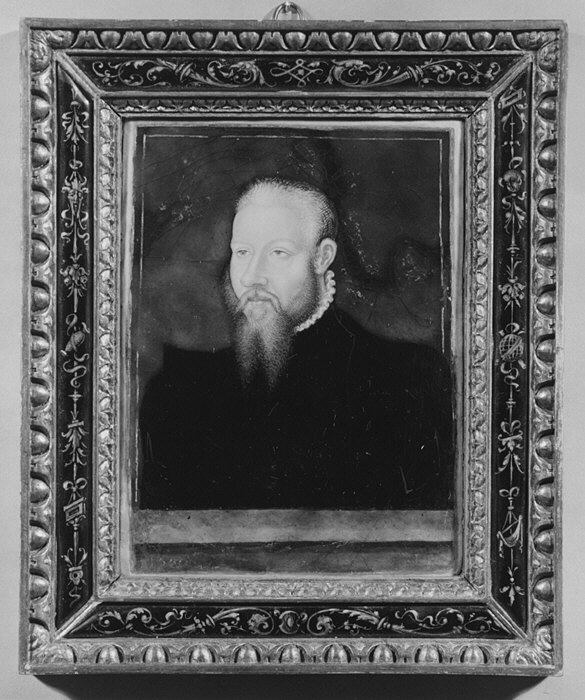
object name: plaque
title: Portrait of an unidentified gentleman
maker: léonard limosin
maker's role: artist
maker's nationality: french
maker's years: 1505-1577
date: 1534-1566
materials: copper, enamel, gilt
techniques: painting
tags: men,portraits